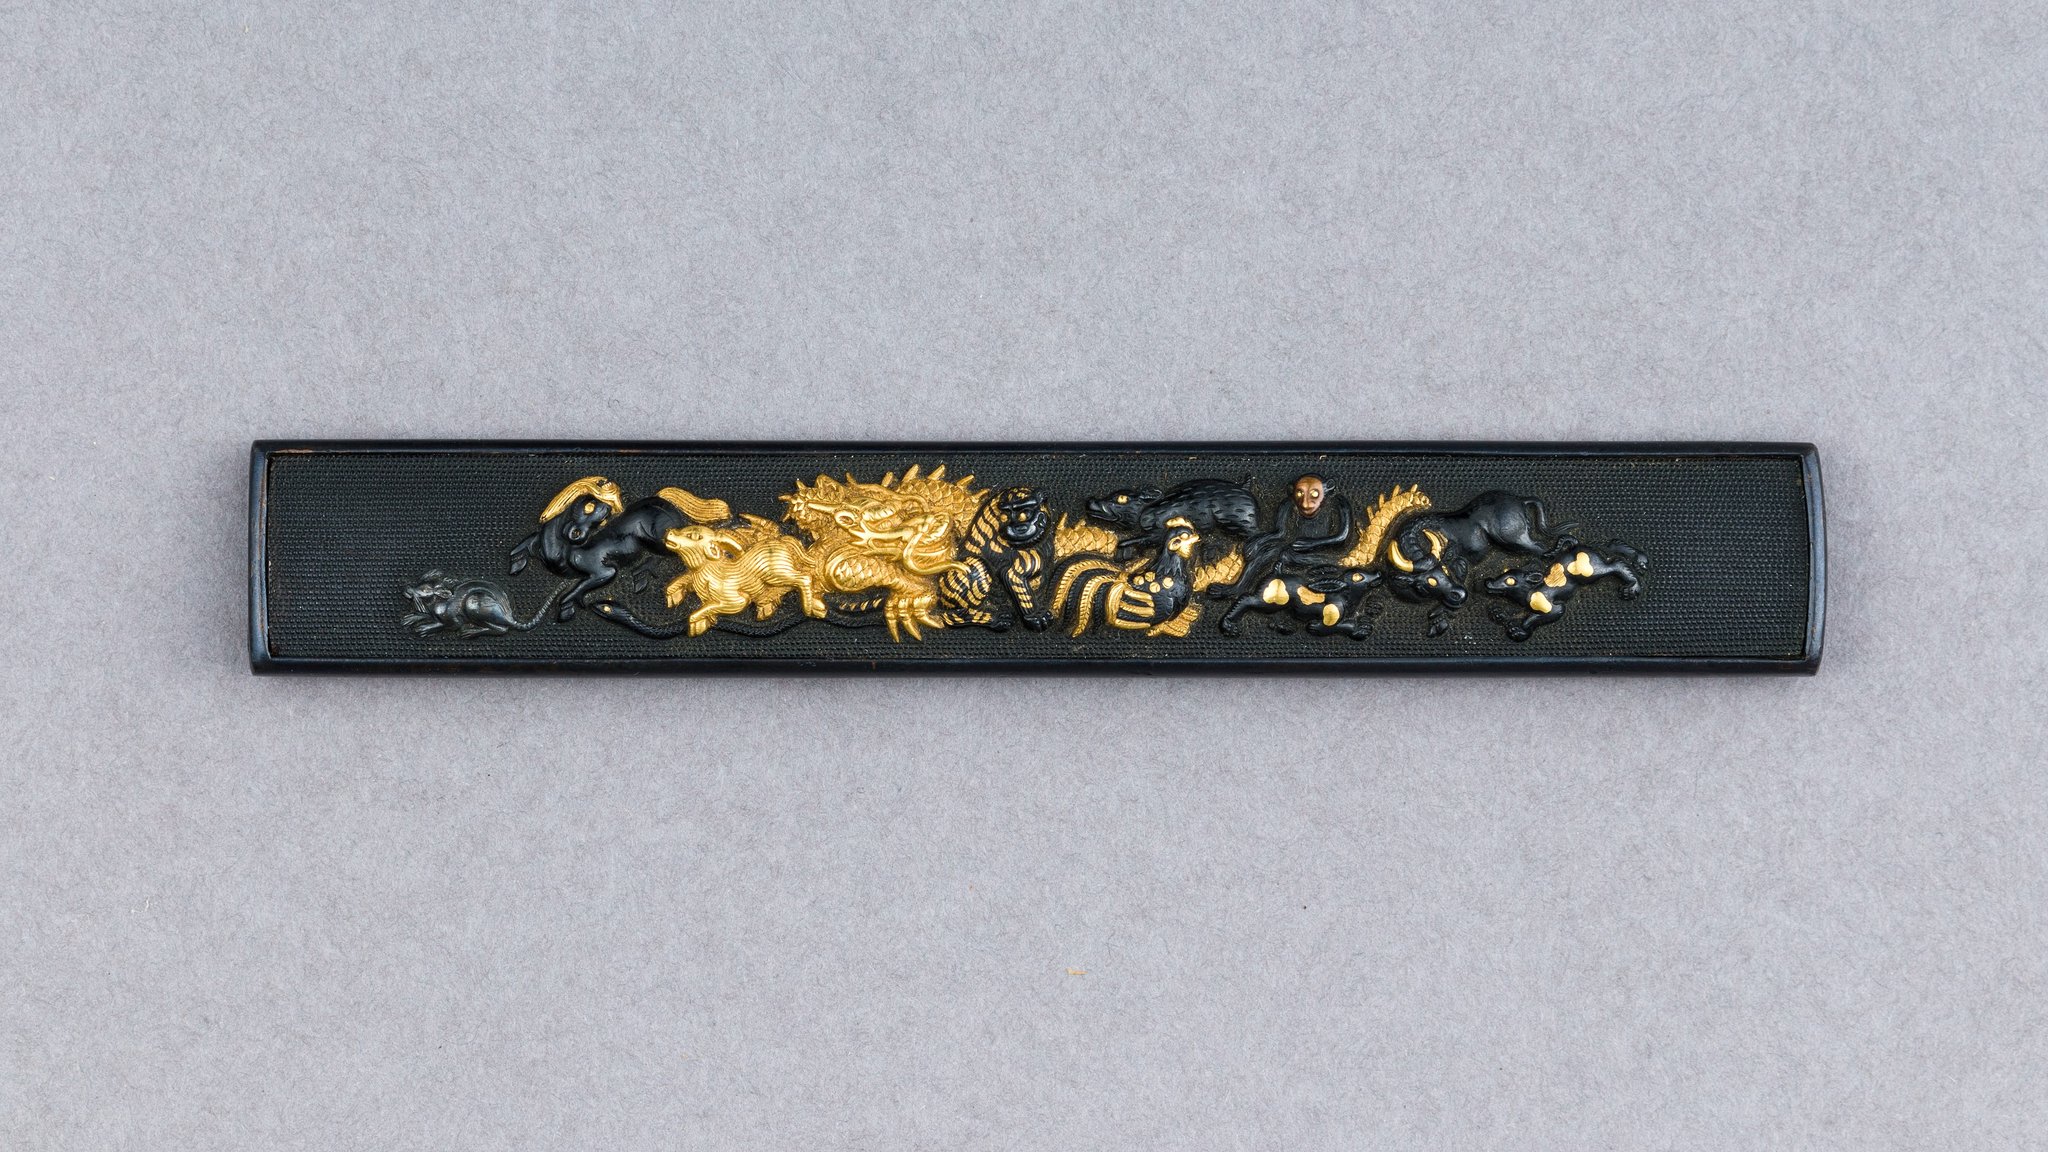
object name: knife handle kozuka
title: Knife Handle (Kozuka)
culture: japanese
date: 1501-1600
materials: copper, gold alloy, silver alloy, gold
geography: japan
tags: dragons,roosters,boars,horses,monkeys,rats